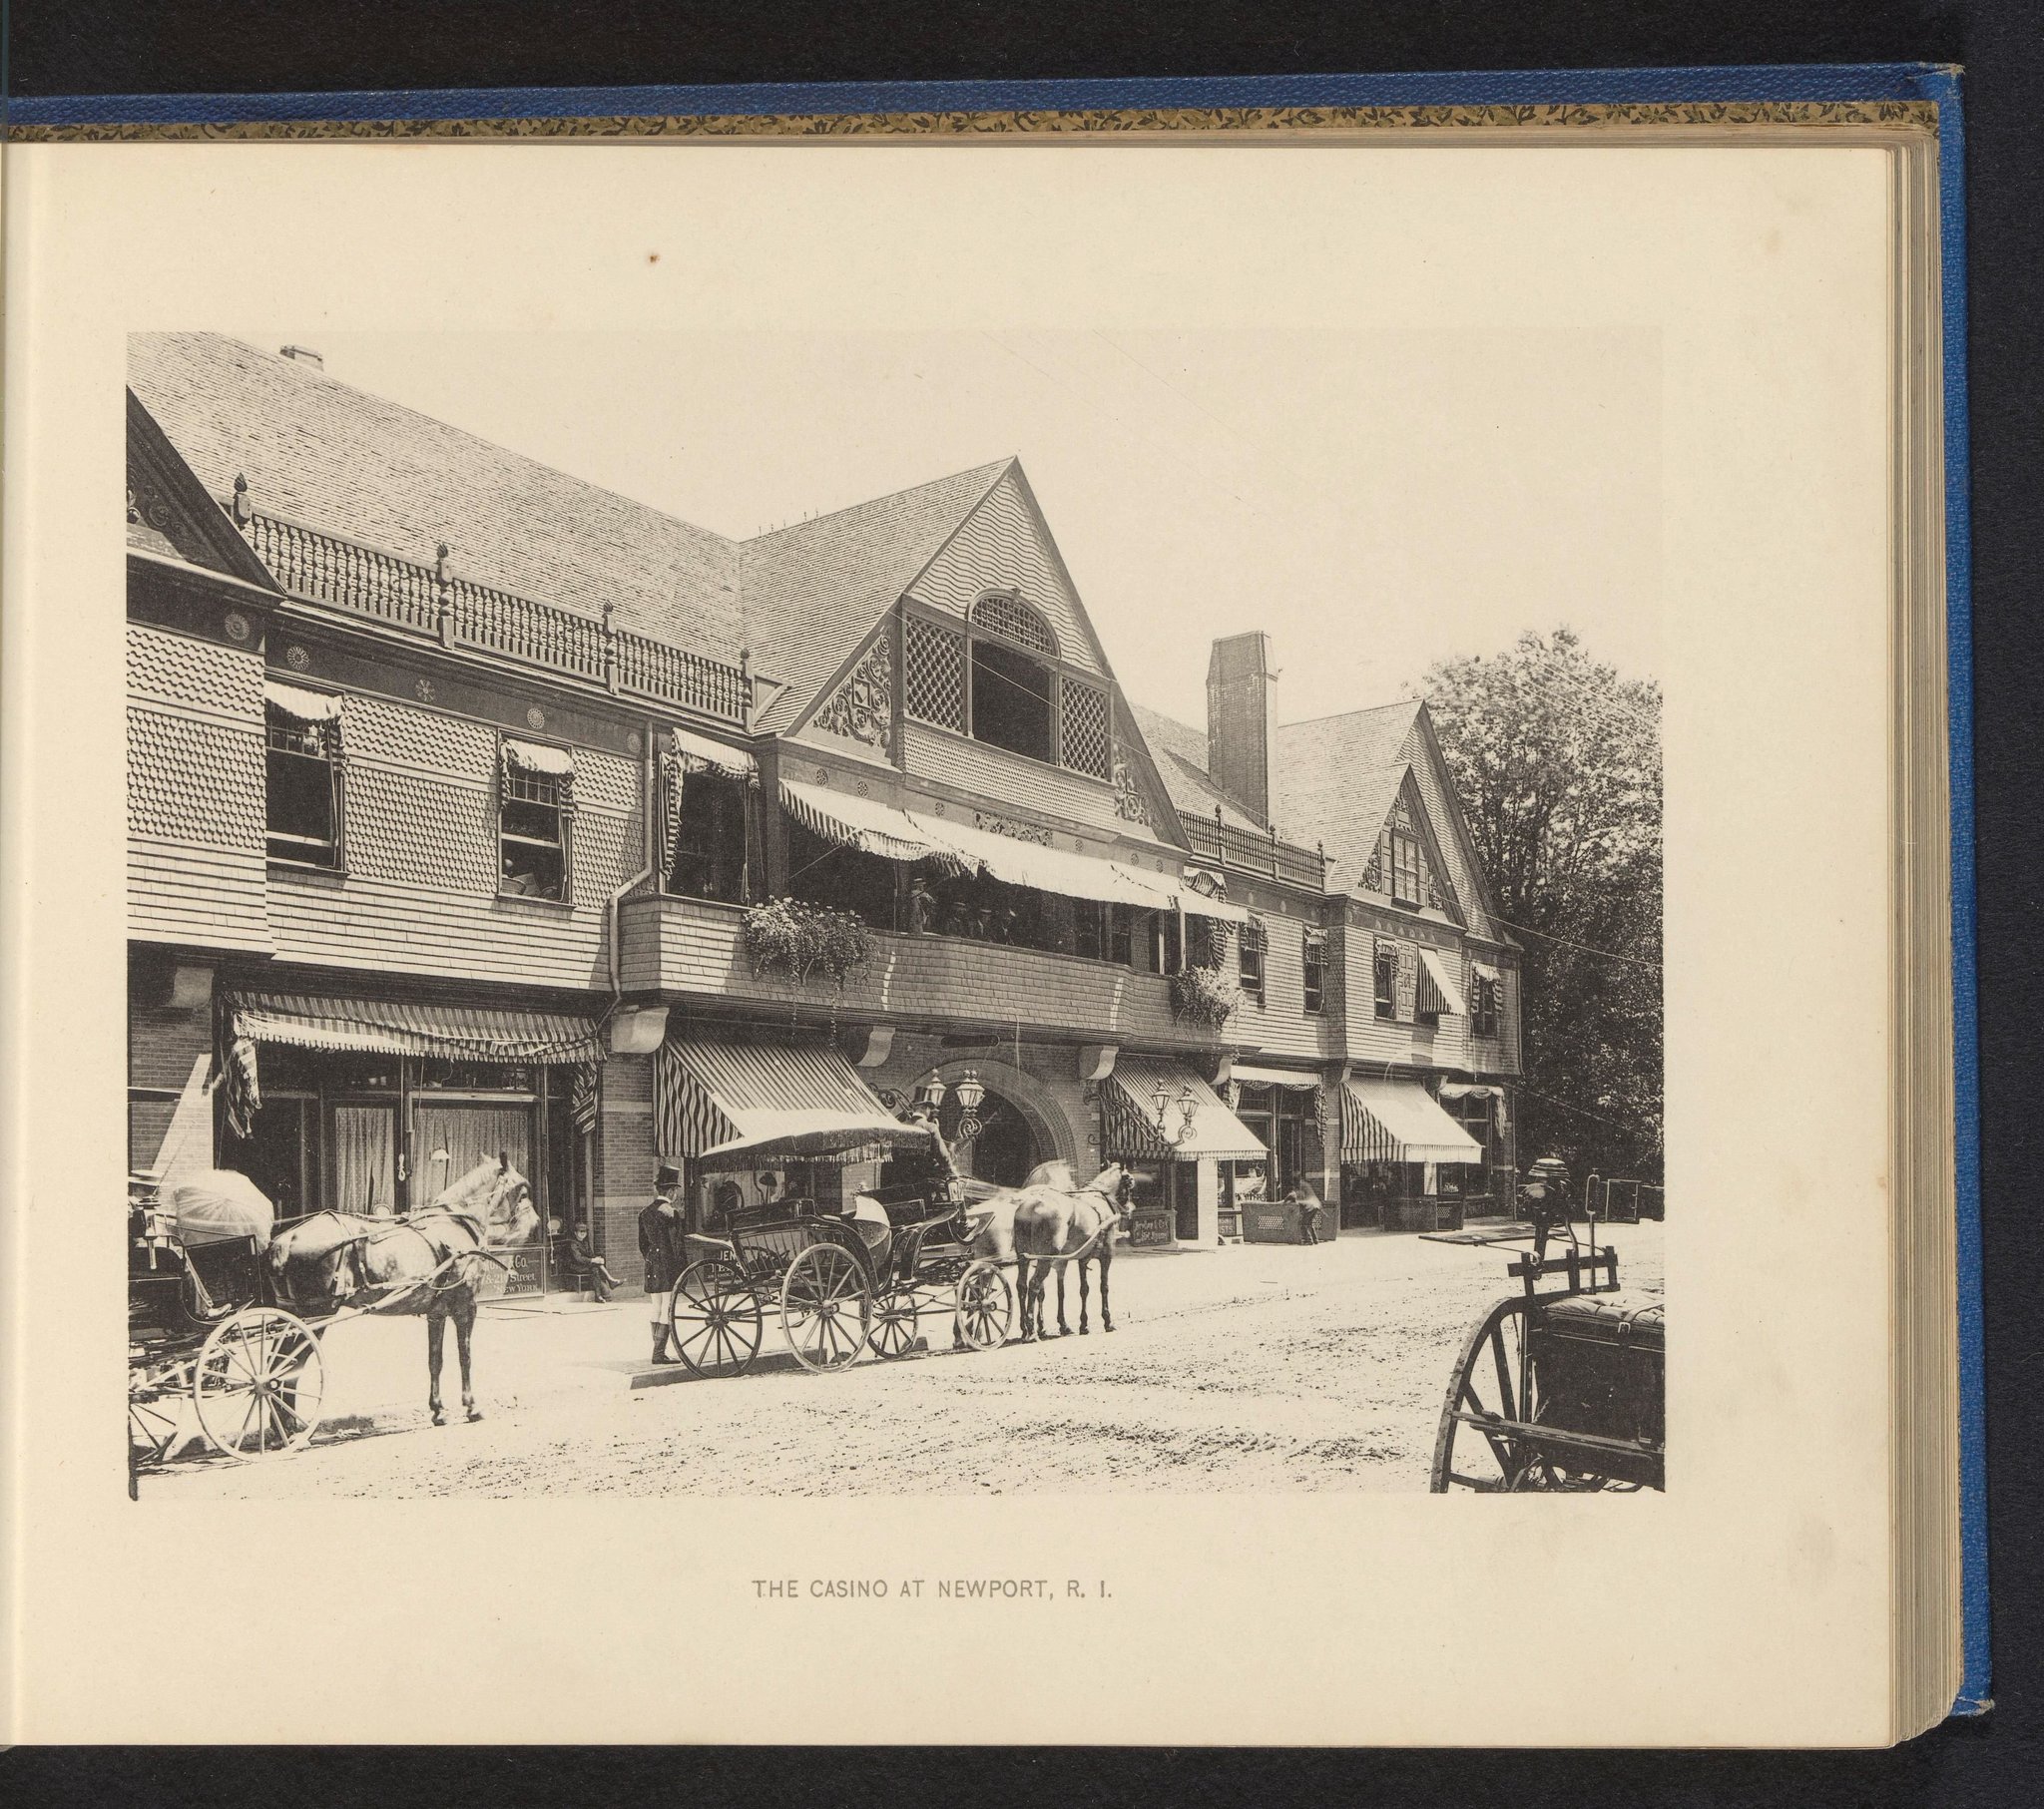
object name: page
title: Gezicht op het casino Newport met koetsen voor de deur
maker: Anonymous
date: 1883-1893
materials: paper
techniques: photograph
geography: newport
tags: four-wheeled, animal-drawn vehicle, e.g.: cab, carriage, coach, casino